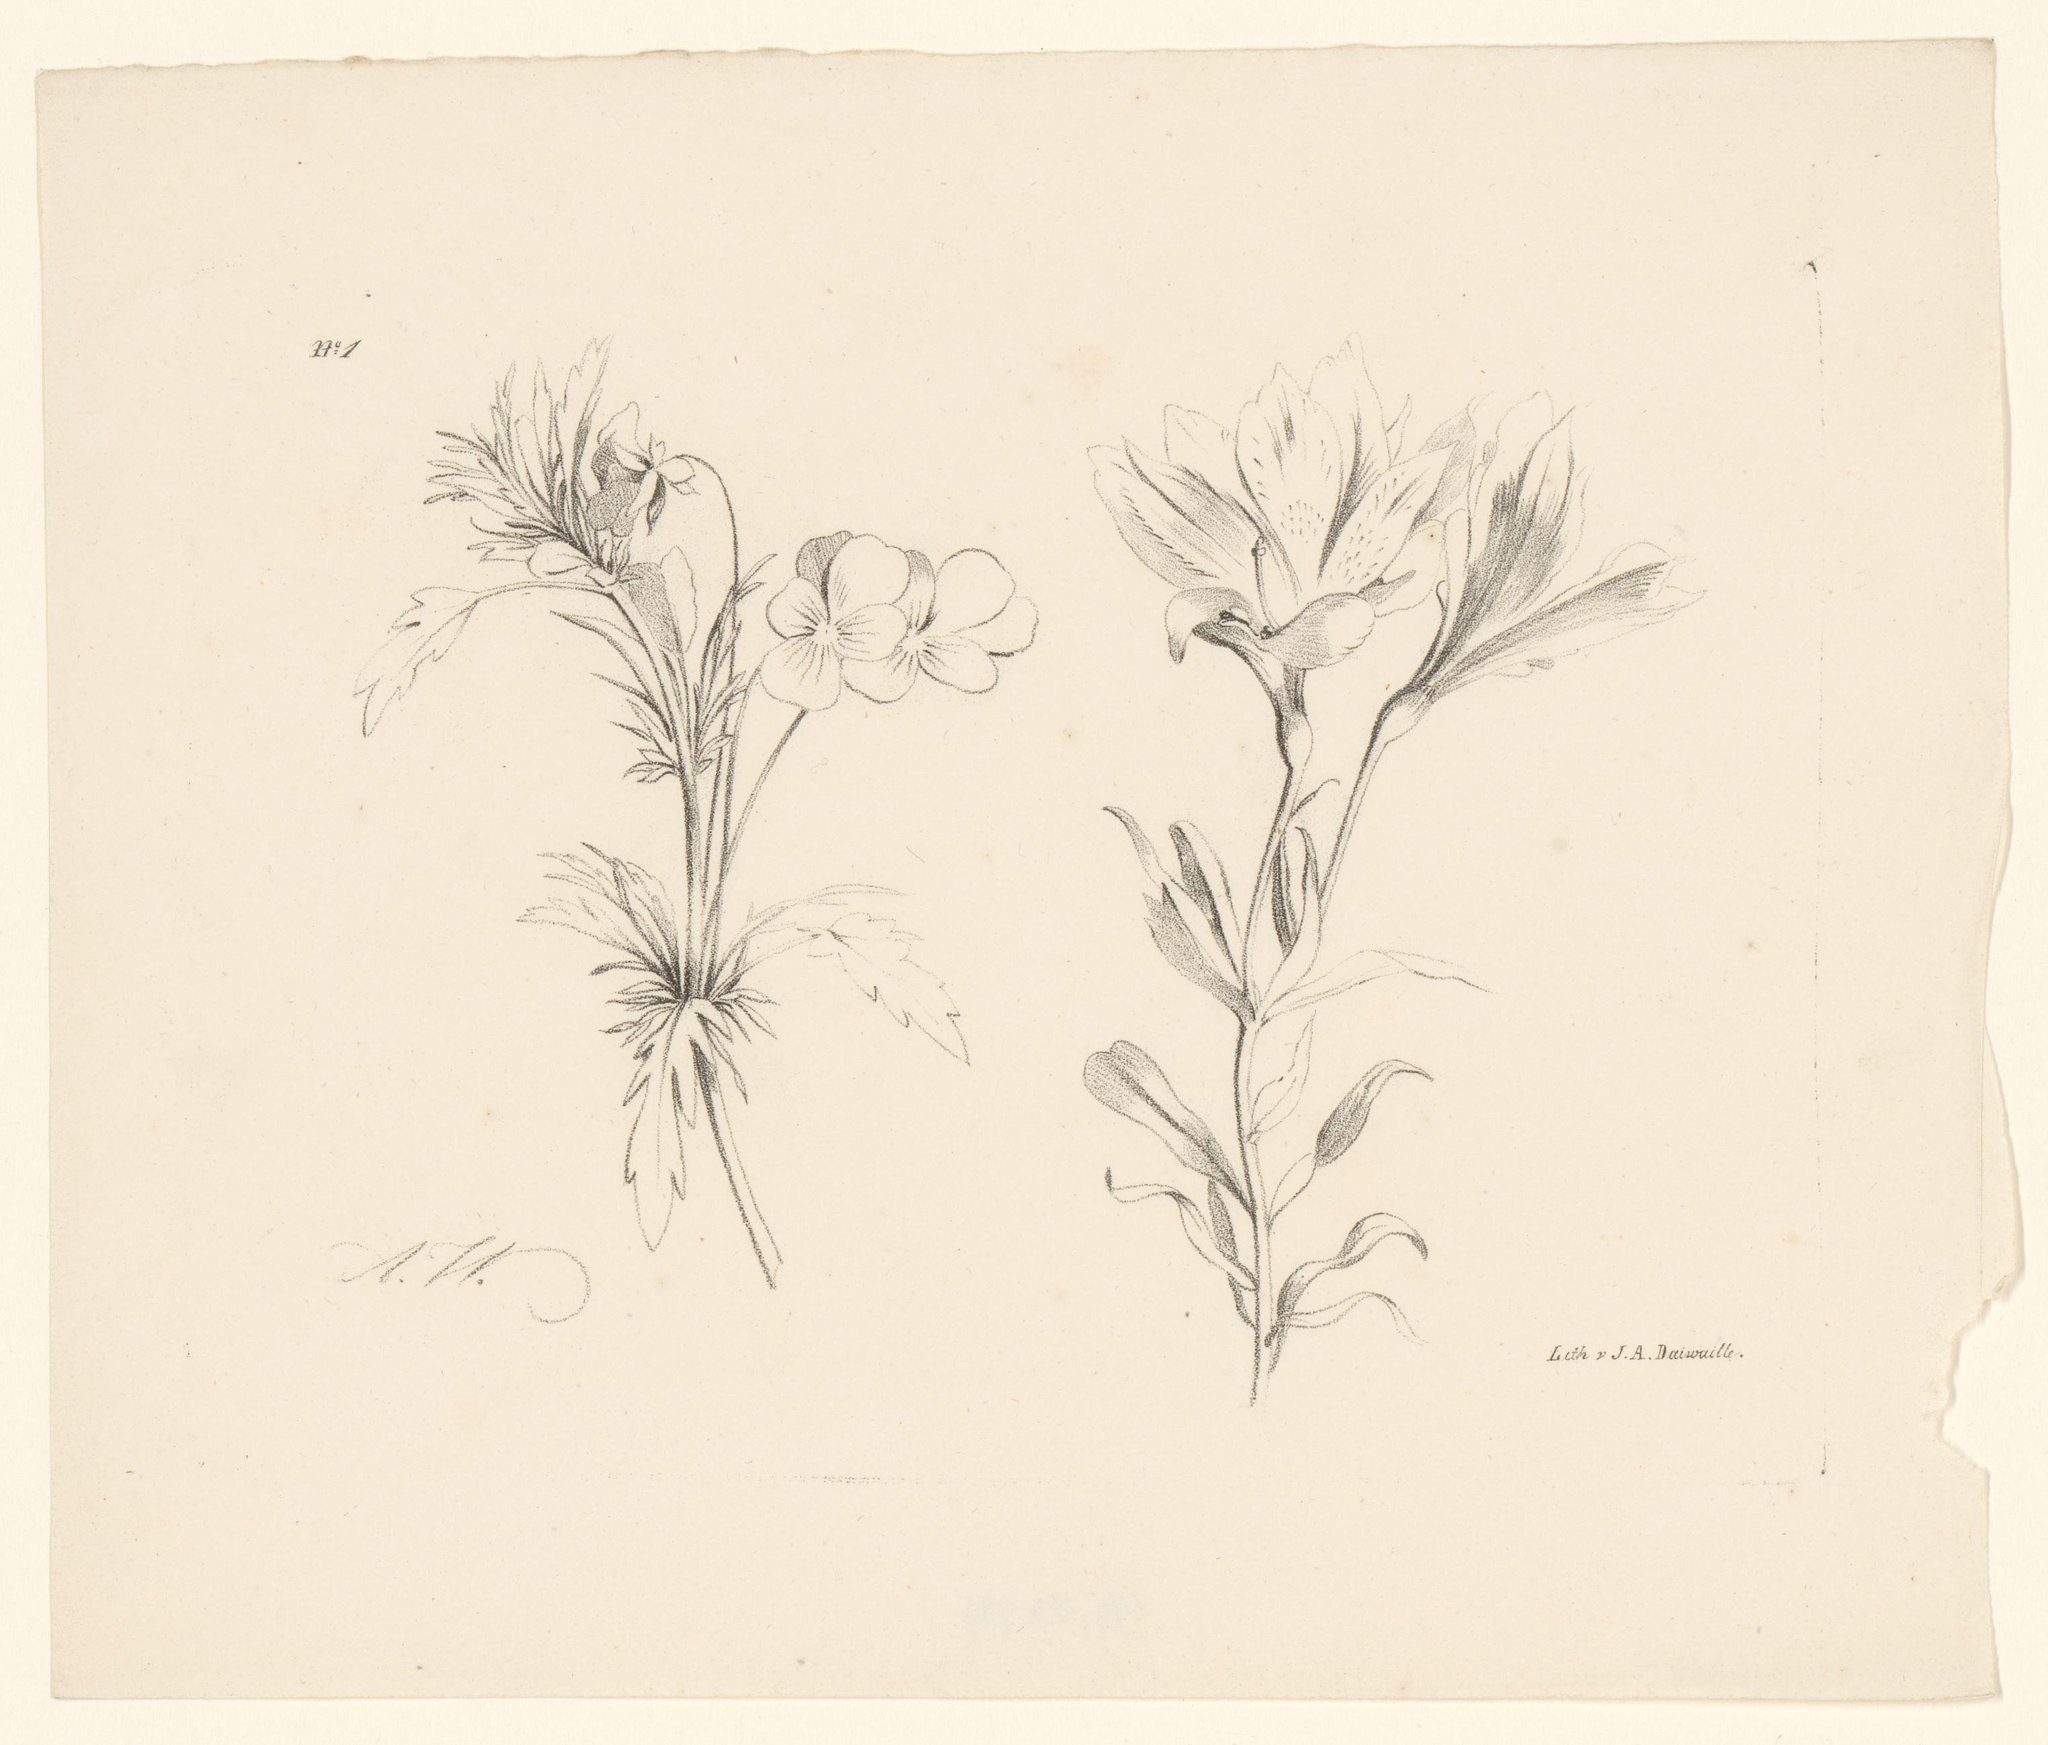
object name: print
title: Twee bloemen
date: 1820-1833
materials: paper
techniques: lithograph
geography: amsterdam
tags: flowers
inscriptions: watermark